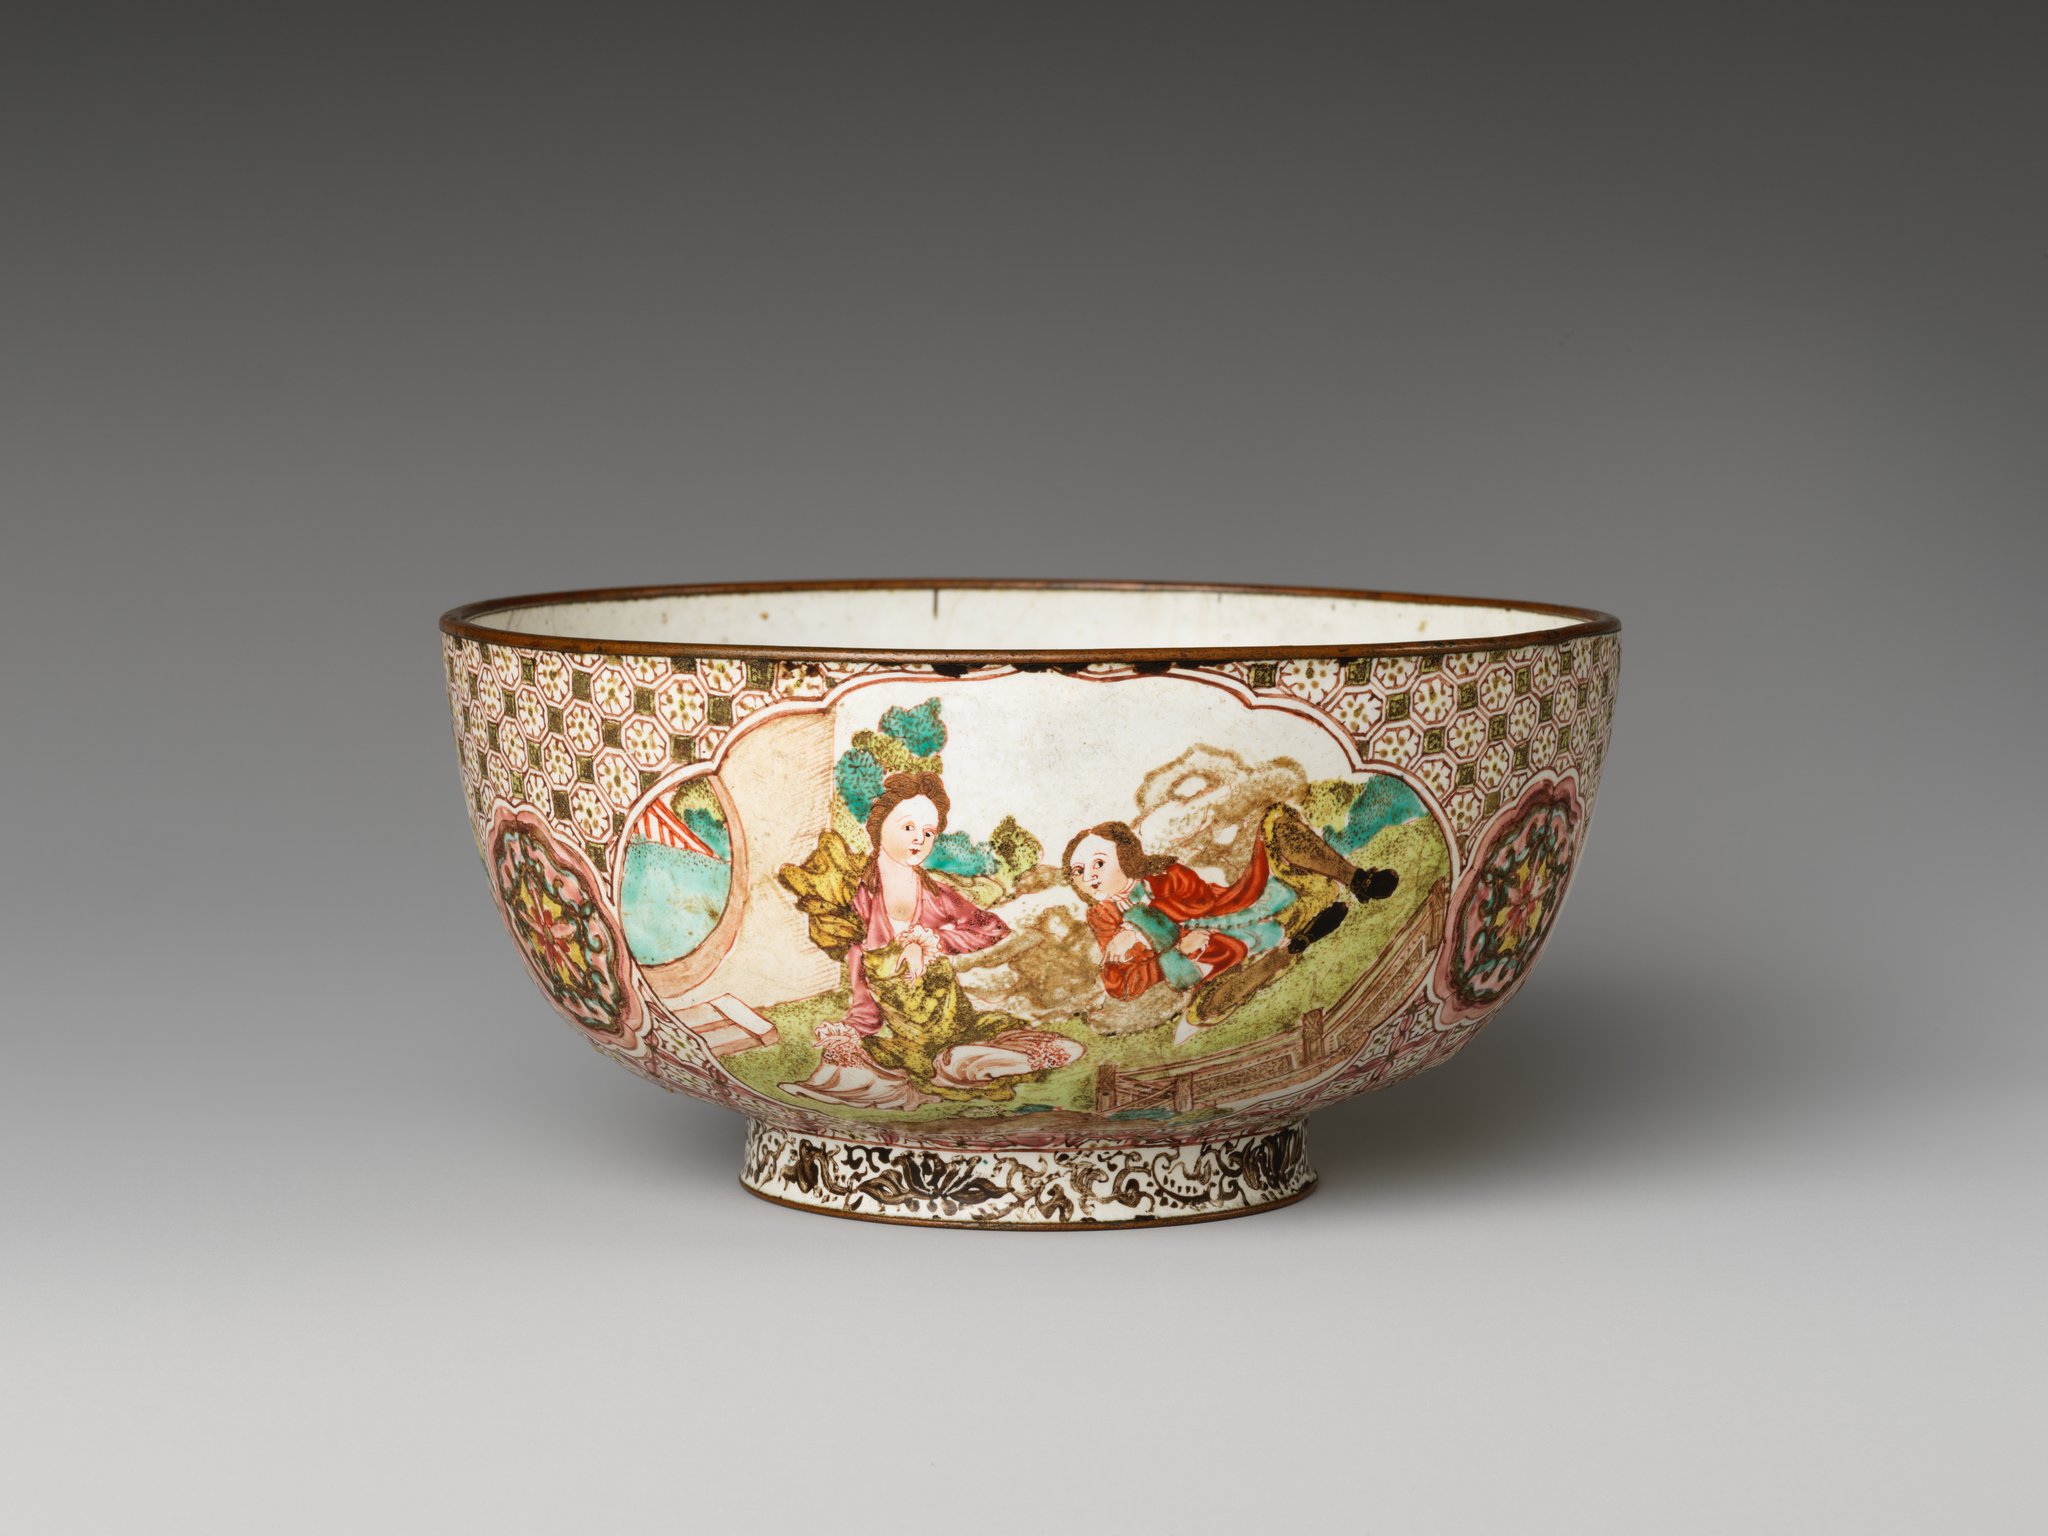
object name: bowl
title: Bowl (one of a pair)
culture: chinese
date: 1736-1795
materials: enamel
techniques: painting